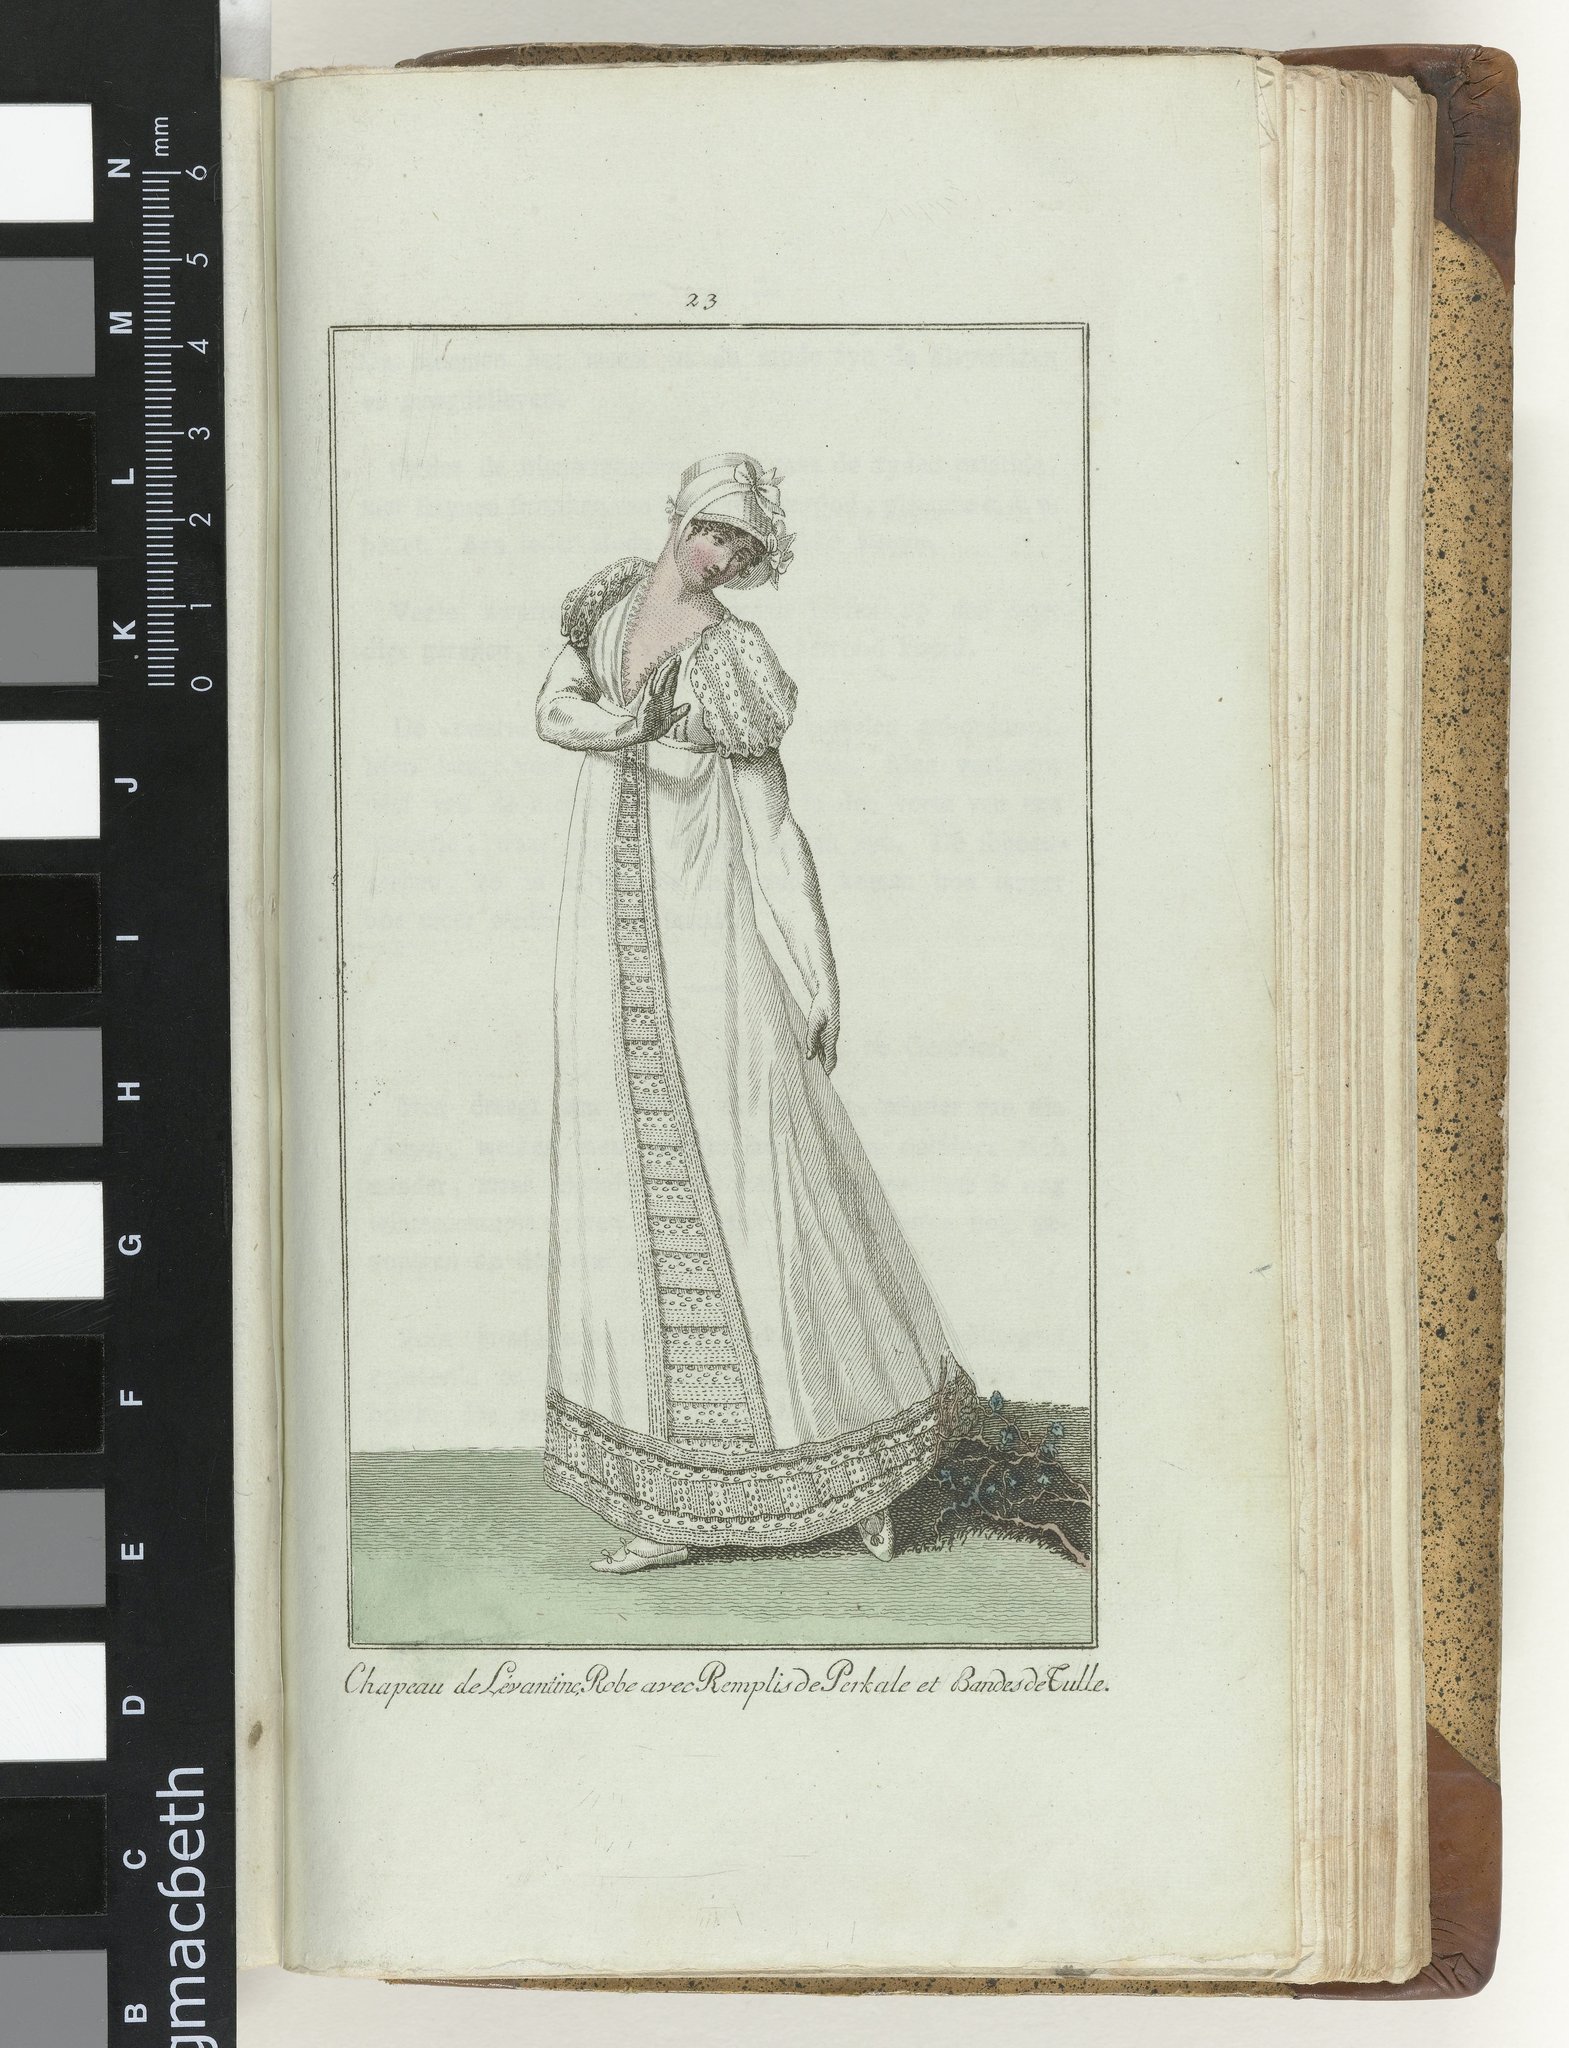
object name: magazine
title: Elegantia, of tijdschrift van mode, luxe en smaak voor dames, Oktober 1807, No. 23: Chapeau de Levantine...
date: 1807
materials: paper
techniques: engraving, hand coloring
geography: amsterdam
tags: gloves, mittens (long gloves) (+ women's clothes), border, ribbon, braid (+ women's clothes), fashion plates, head-gear: hat (+ women's clothes), shoes, sandals (+ women's clothes), dress, gown (+ women's clothes)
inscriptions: caption: ‘Chapeau de Lévantine. Robe avec Remplis de Perkale et Bandes de Tulle.’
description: Volgens de begeleidende tekst (p. 328): Japon van witte mousseline met 'remplis' van katoenbatist (percale) en tule. Korte pofmouwen met dezelfde versiering. Wit satijnen 'Chapeau de lévantine'. Witte handschoenen en schoenen. Prent uit het modetijdschrift Elegantia, of tijdschrift van mode, luxe en smaak voor dames 1807-1814 (onderbroken door de periode 1811-1813).